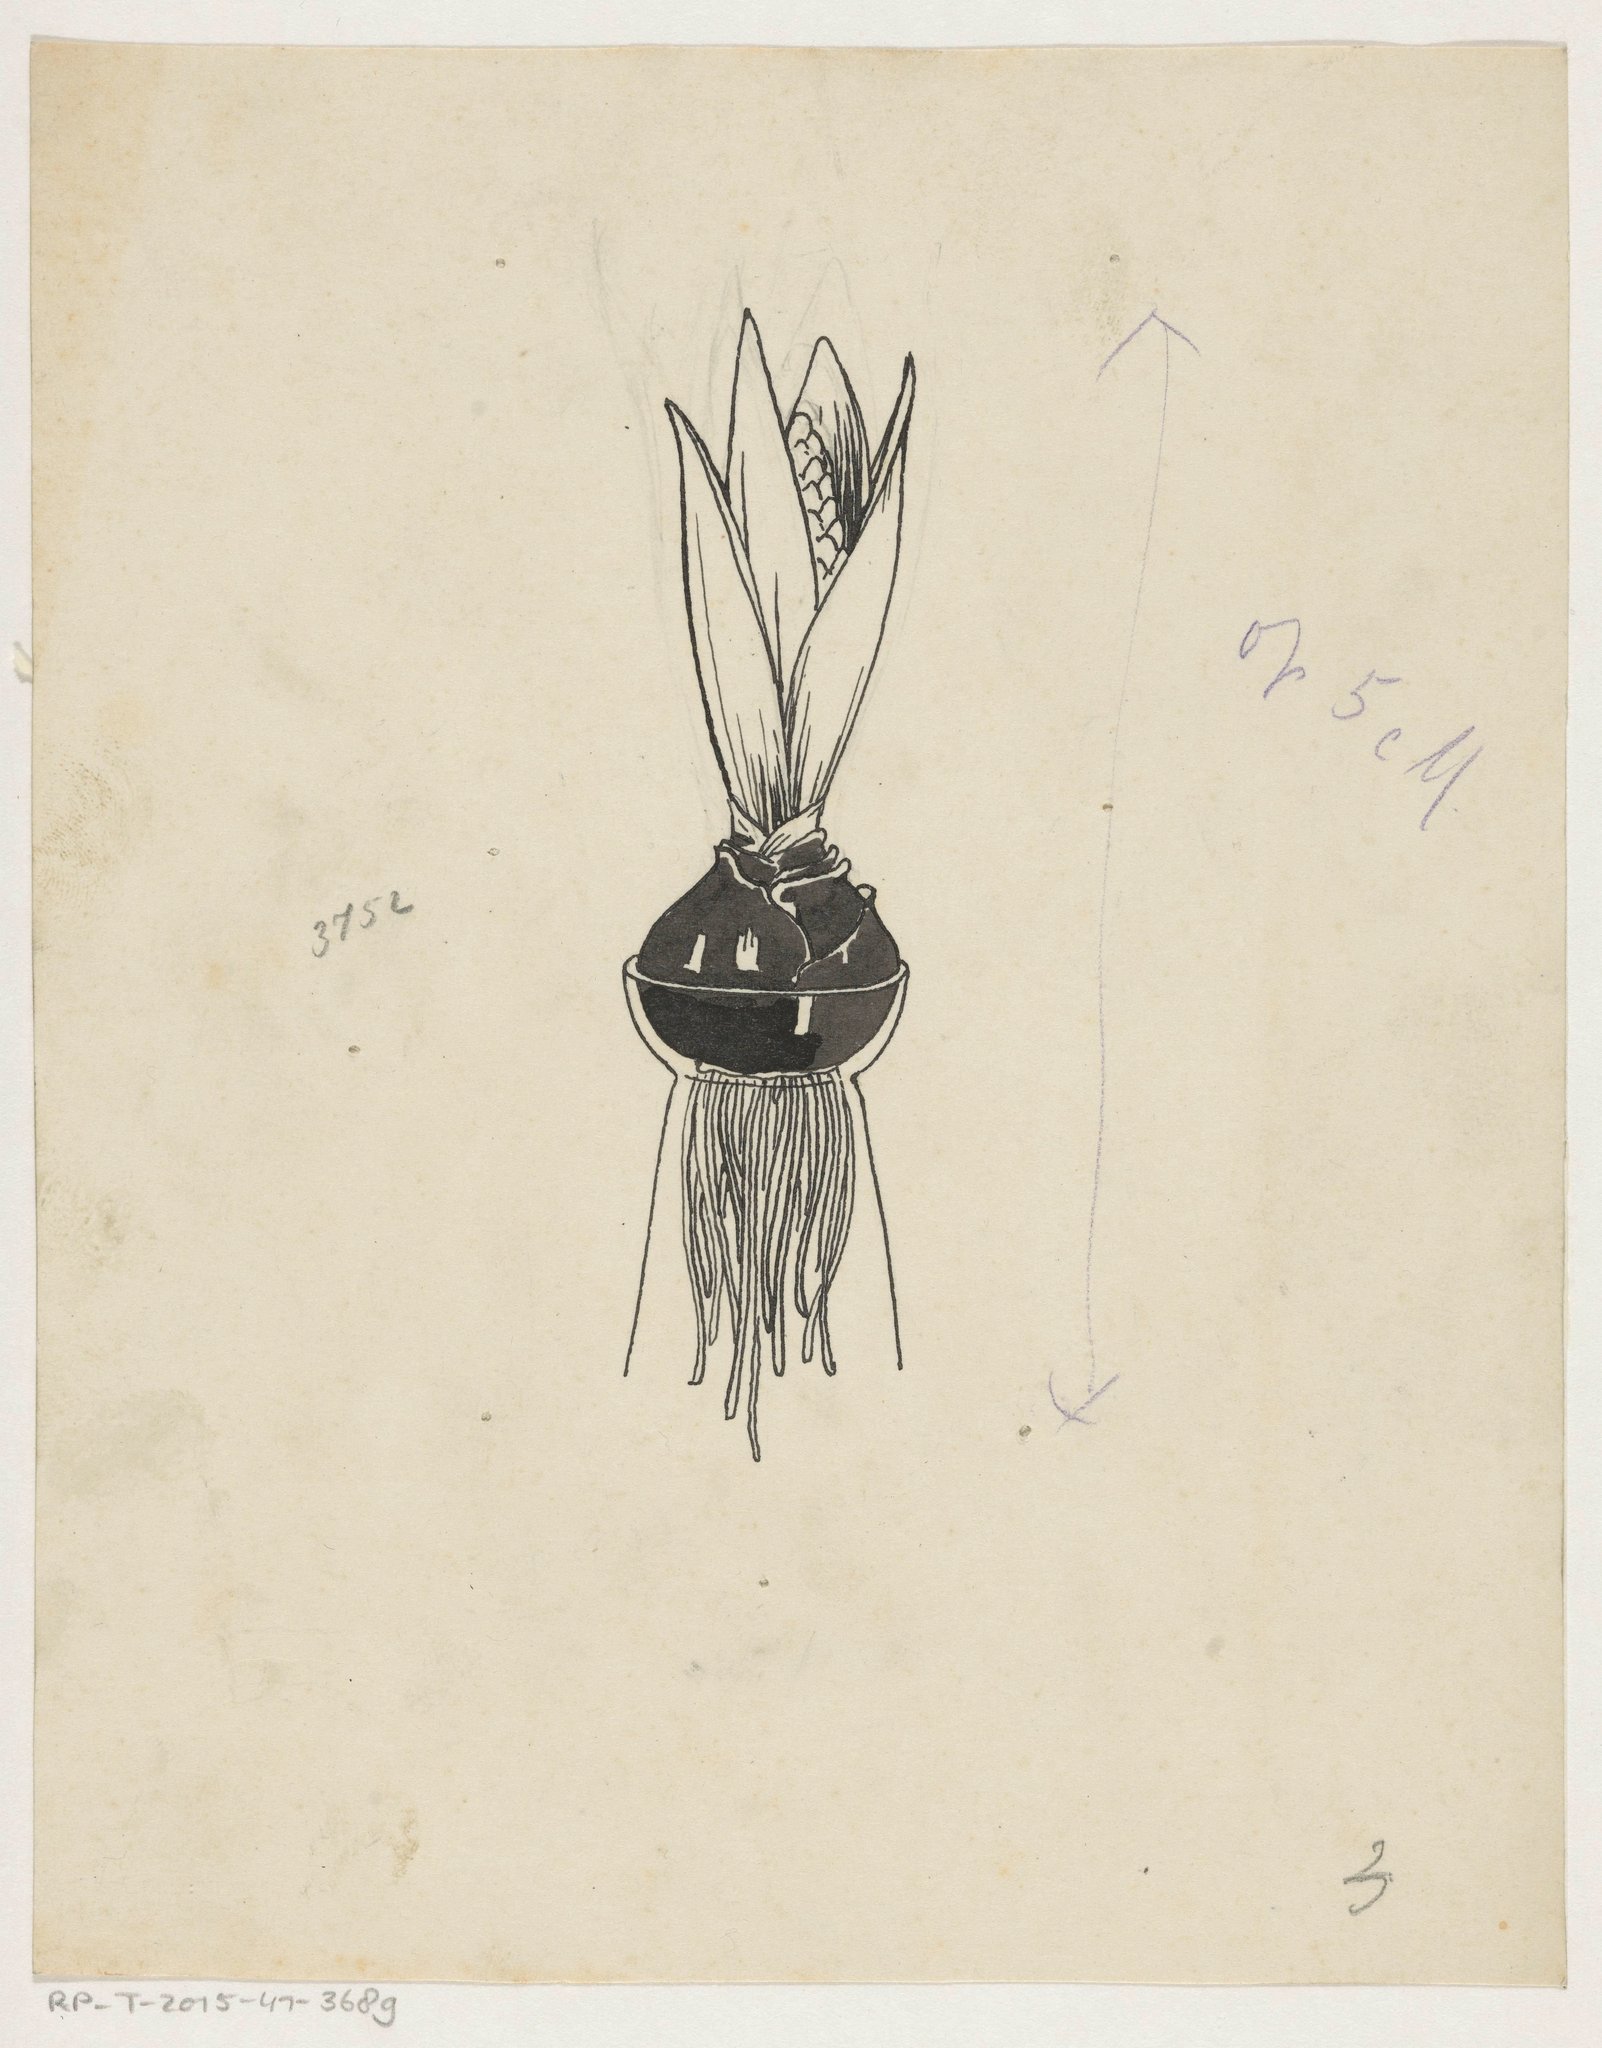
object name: drawing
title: Hyacint met bol en wortels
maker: Anonymous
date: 1880-1930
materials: ink, paper, pencil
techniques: brush, pen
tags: flowers: hyacinth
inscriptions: :, collector's mark: Lugt 2228a, number: ‘3’